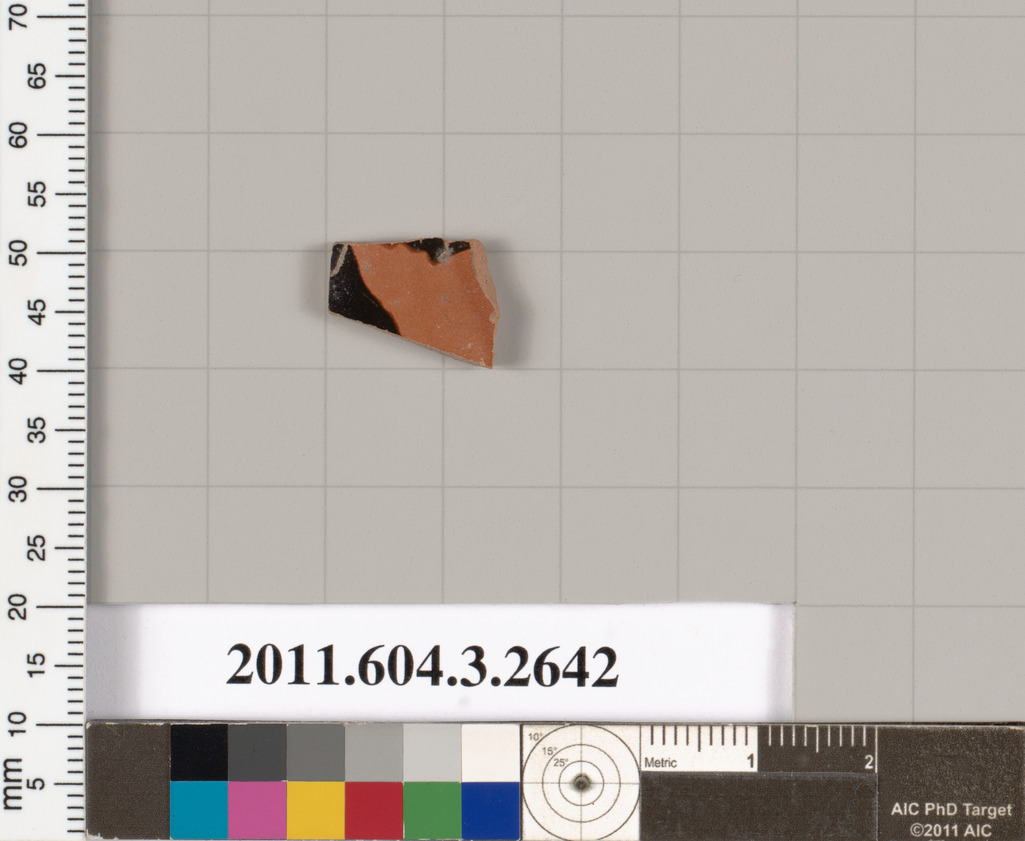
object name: undetermined closed shape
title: Terracotta fragment of a closed shape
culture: greek, attic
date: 600-401 BCE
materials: terracotta